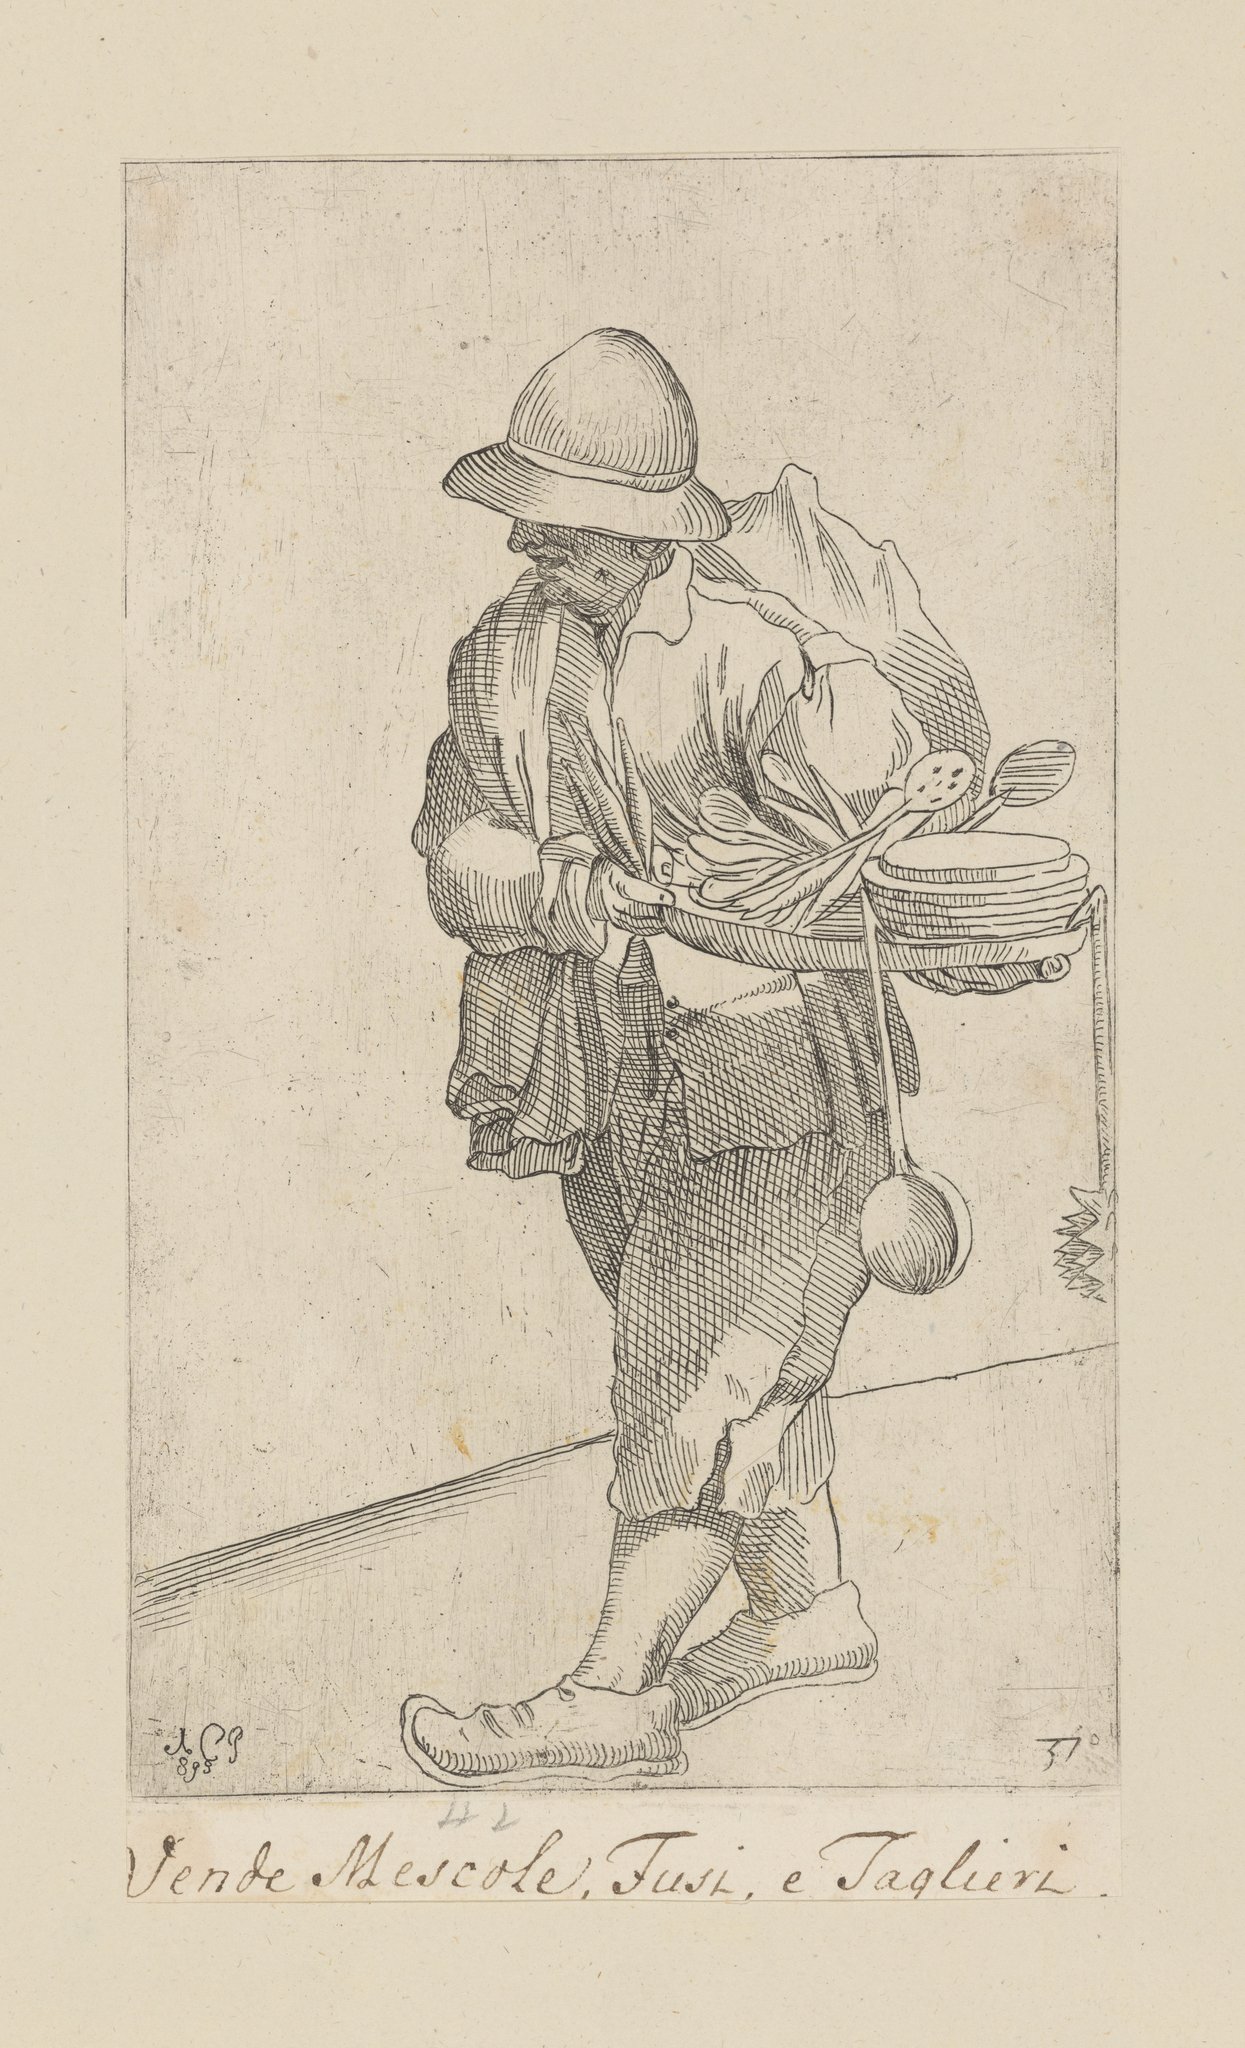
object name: print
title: Plate 37: Vendor of spoons, ladels etc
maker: simon guillain ii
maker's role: artist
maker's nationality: french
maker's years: 1618-1718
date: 1646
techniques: etching